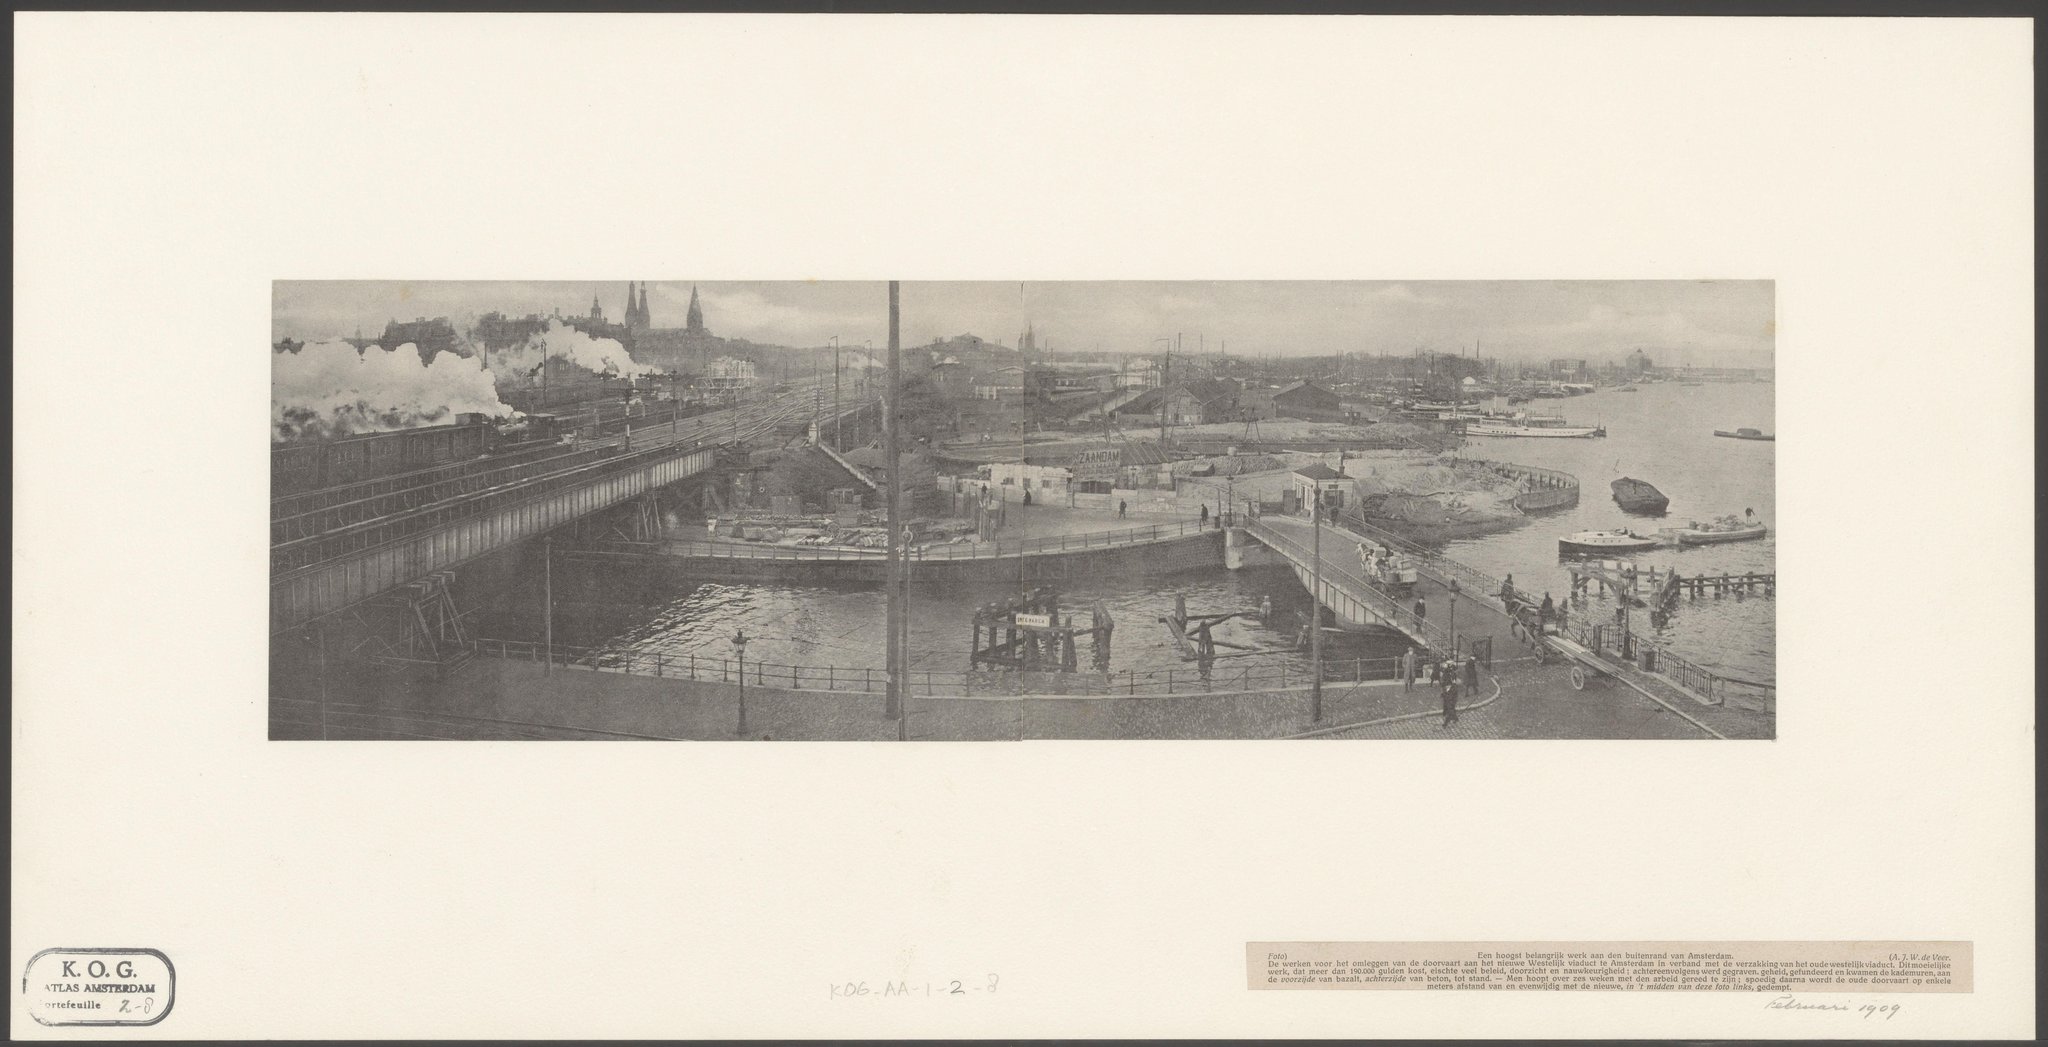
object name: photomechanical print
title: Gezicht op bouwwerkzaamheden rondom een doorvaart in Amsterdam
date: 1902-1909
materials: paper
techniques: autotype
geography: amsterdam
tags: city-view in general; 'veduta', canal, building-site, amsterdam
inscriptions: inscription: ‘Een hoogst belangrijk (...) foto links, gedempt.’, collector's mark: ‘2-8’ Lugt 1641b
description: Onderwerpsrubriek binnen de Atlas Amsterdam: Gezichten van het IJ op het westelijk gedeelte der stad, Blauwhoofd tot Nieuwebrug.